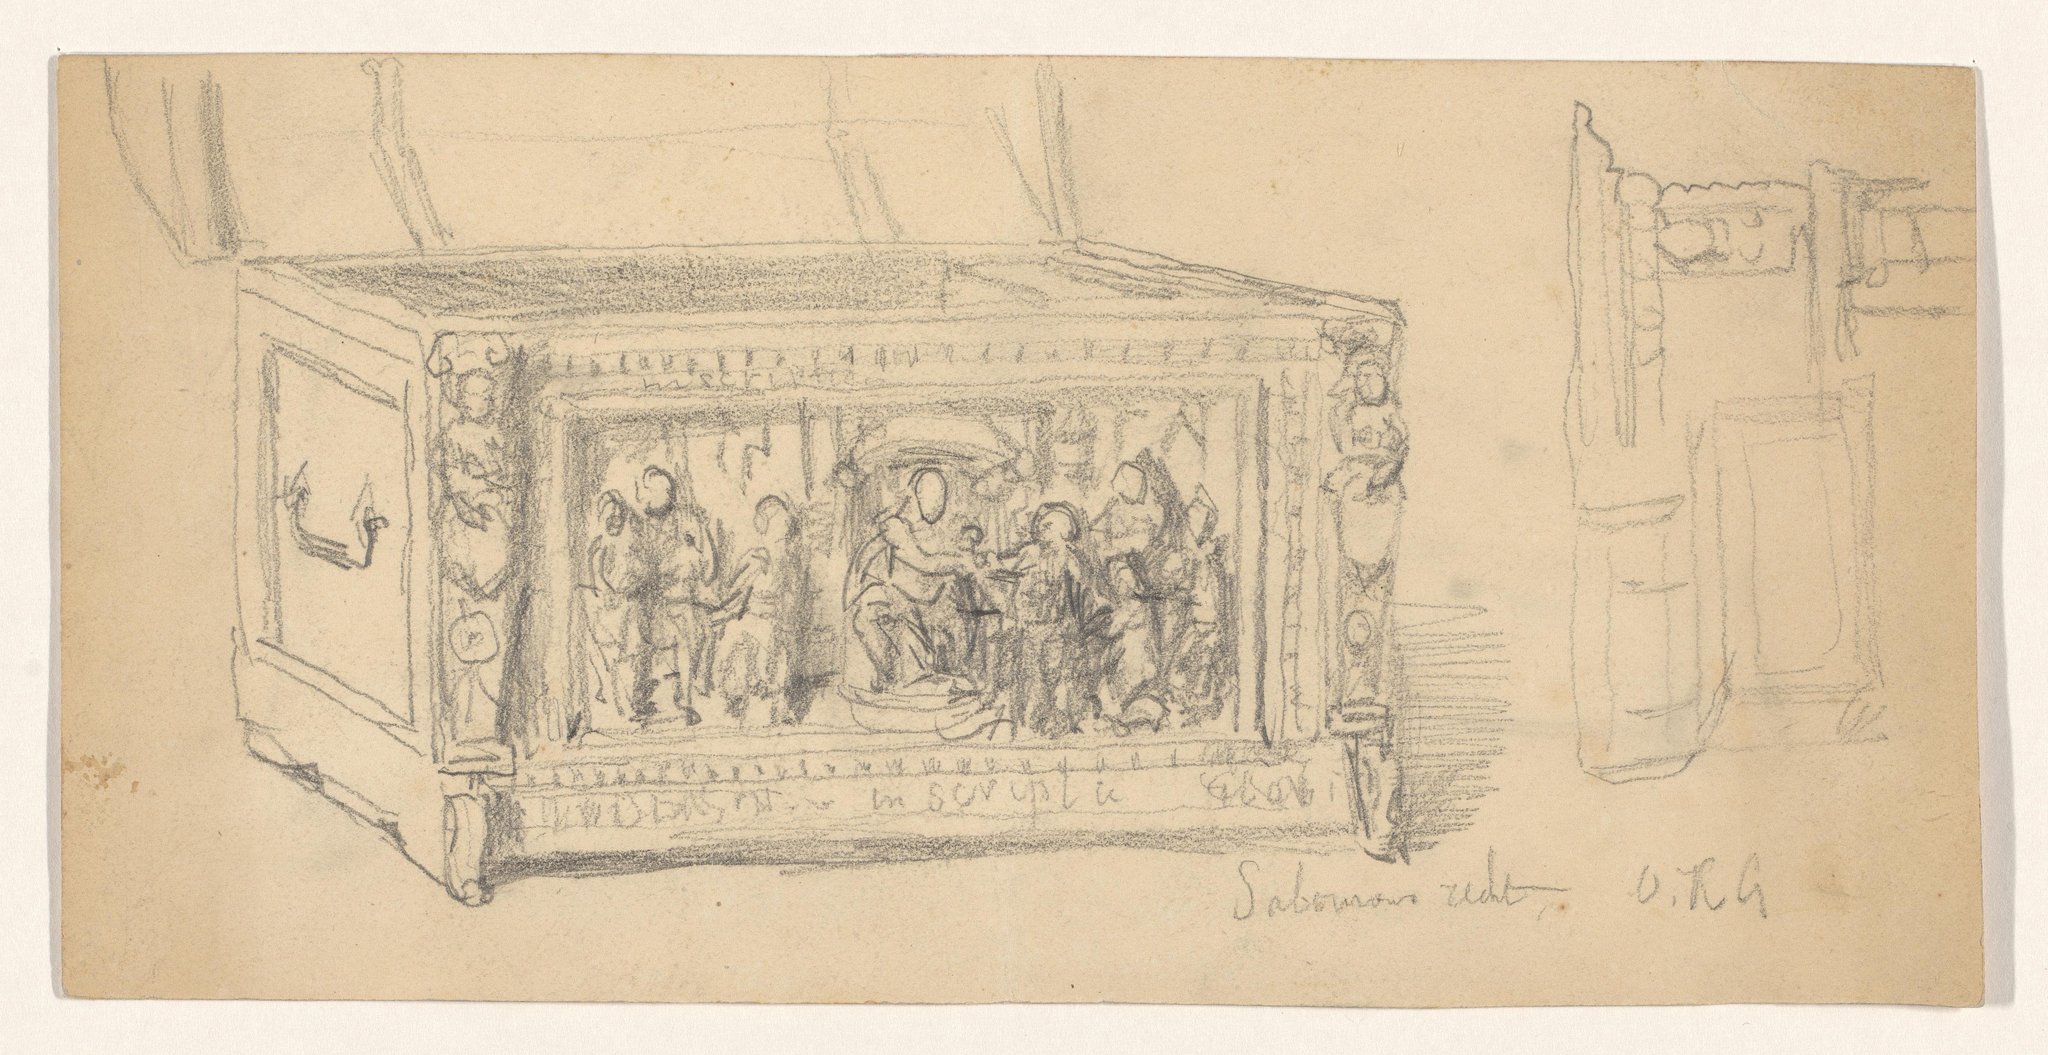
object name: drawing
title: Tekening van een openstaande lakenkist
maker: jacob taanman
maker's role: draughtsman, print maker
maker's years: 1836-1923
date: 1848-1923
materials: paper, pencil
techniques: drawing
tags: chest, coffer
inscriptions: inscription: ‘Sabourous recht, O.R.G.’